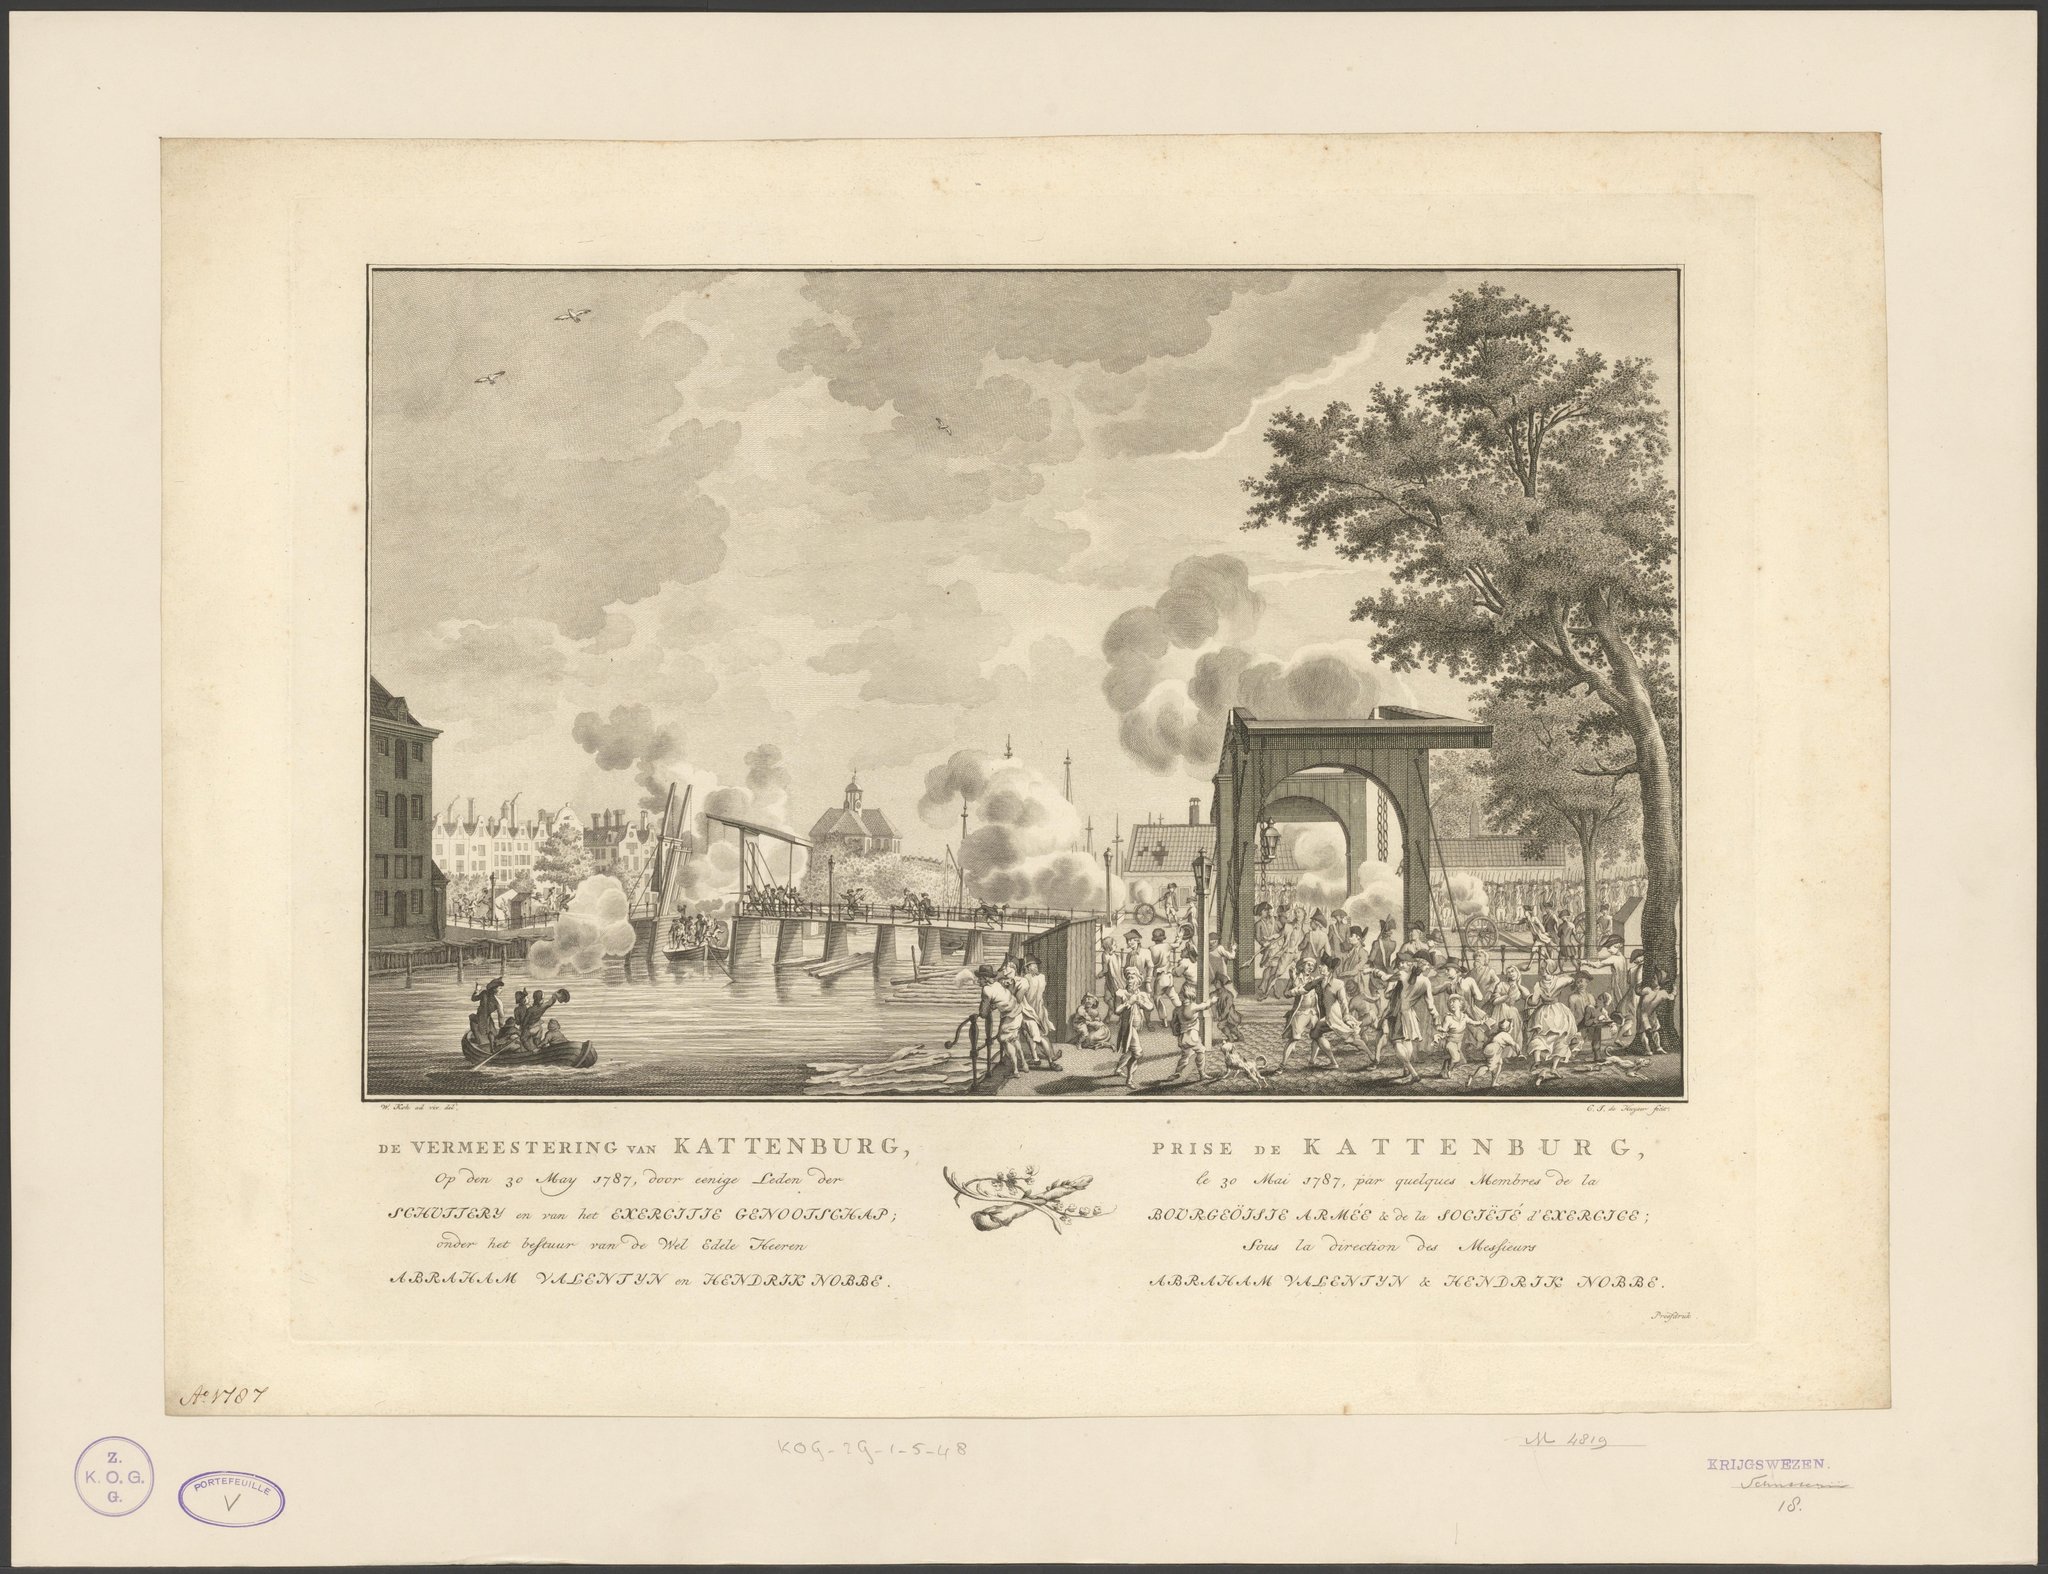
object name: print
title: Aanval op Kattenburg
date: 1787-1789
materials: paper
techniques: engraving, etching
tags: bridge, defence ~ siege, patriots (1780-1795)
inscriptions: collector's mark: Lugt 1641, stamp, stamp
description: Aanval op Kattenburg, Amsterdam, door de patriotten. Rechts ligt de wijk Kattenburg, achter de brug de Oosterkerk. De inwoners van Kattenburg, veelal scheepsbouwers, waren aanhangers van stadhouder Willem V. Toen de patriotten in 1787 aan de macht kwamen stuurden zij de schutterij naar Kattenburg. Bij de Kattenburgerbrug ontstond op 30 mei 1787 een gevecht tussen de twee partijen, waarbij de orangisten de brug ophaalden. Onderwerpsrubrieken binnen de Atlas Zeden en Gewoonten: Krijgswezen, Schutterij, Historieprenten.